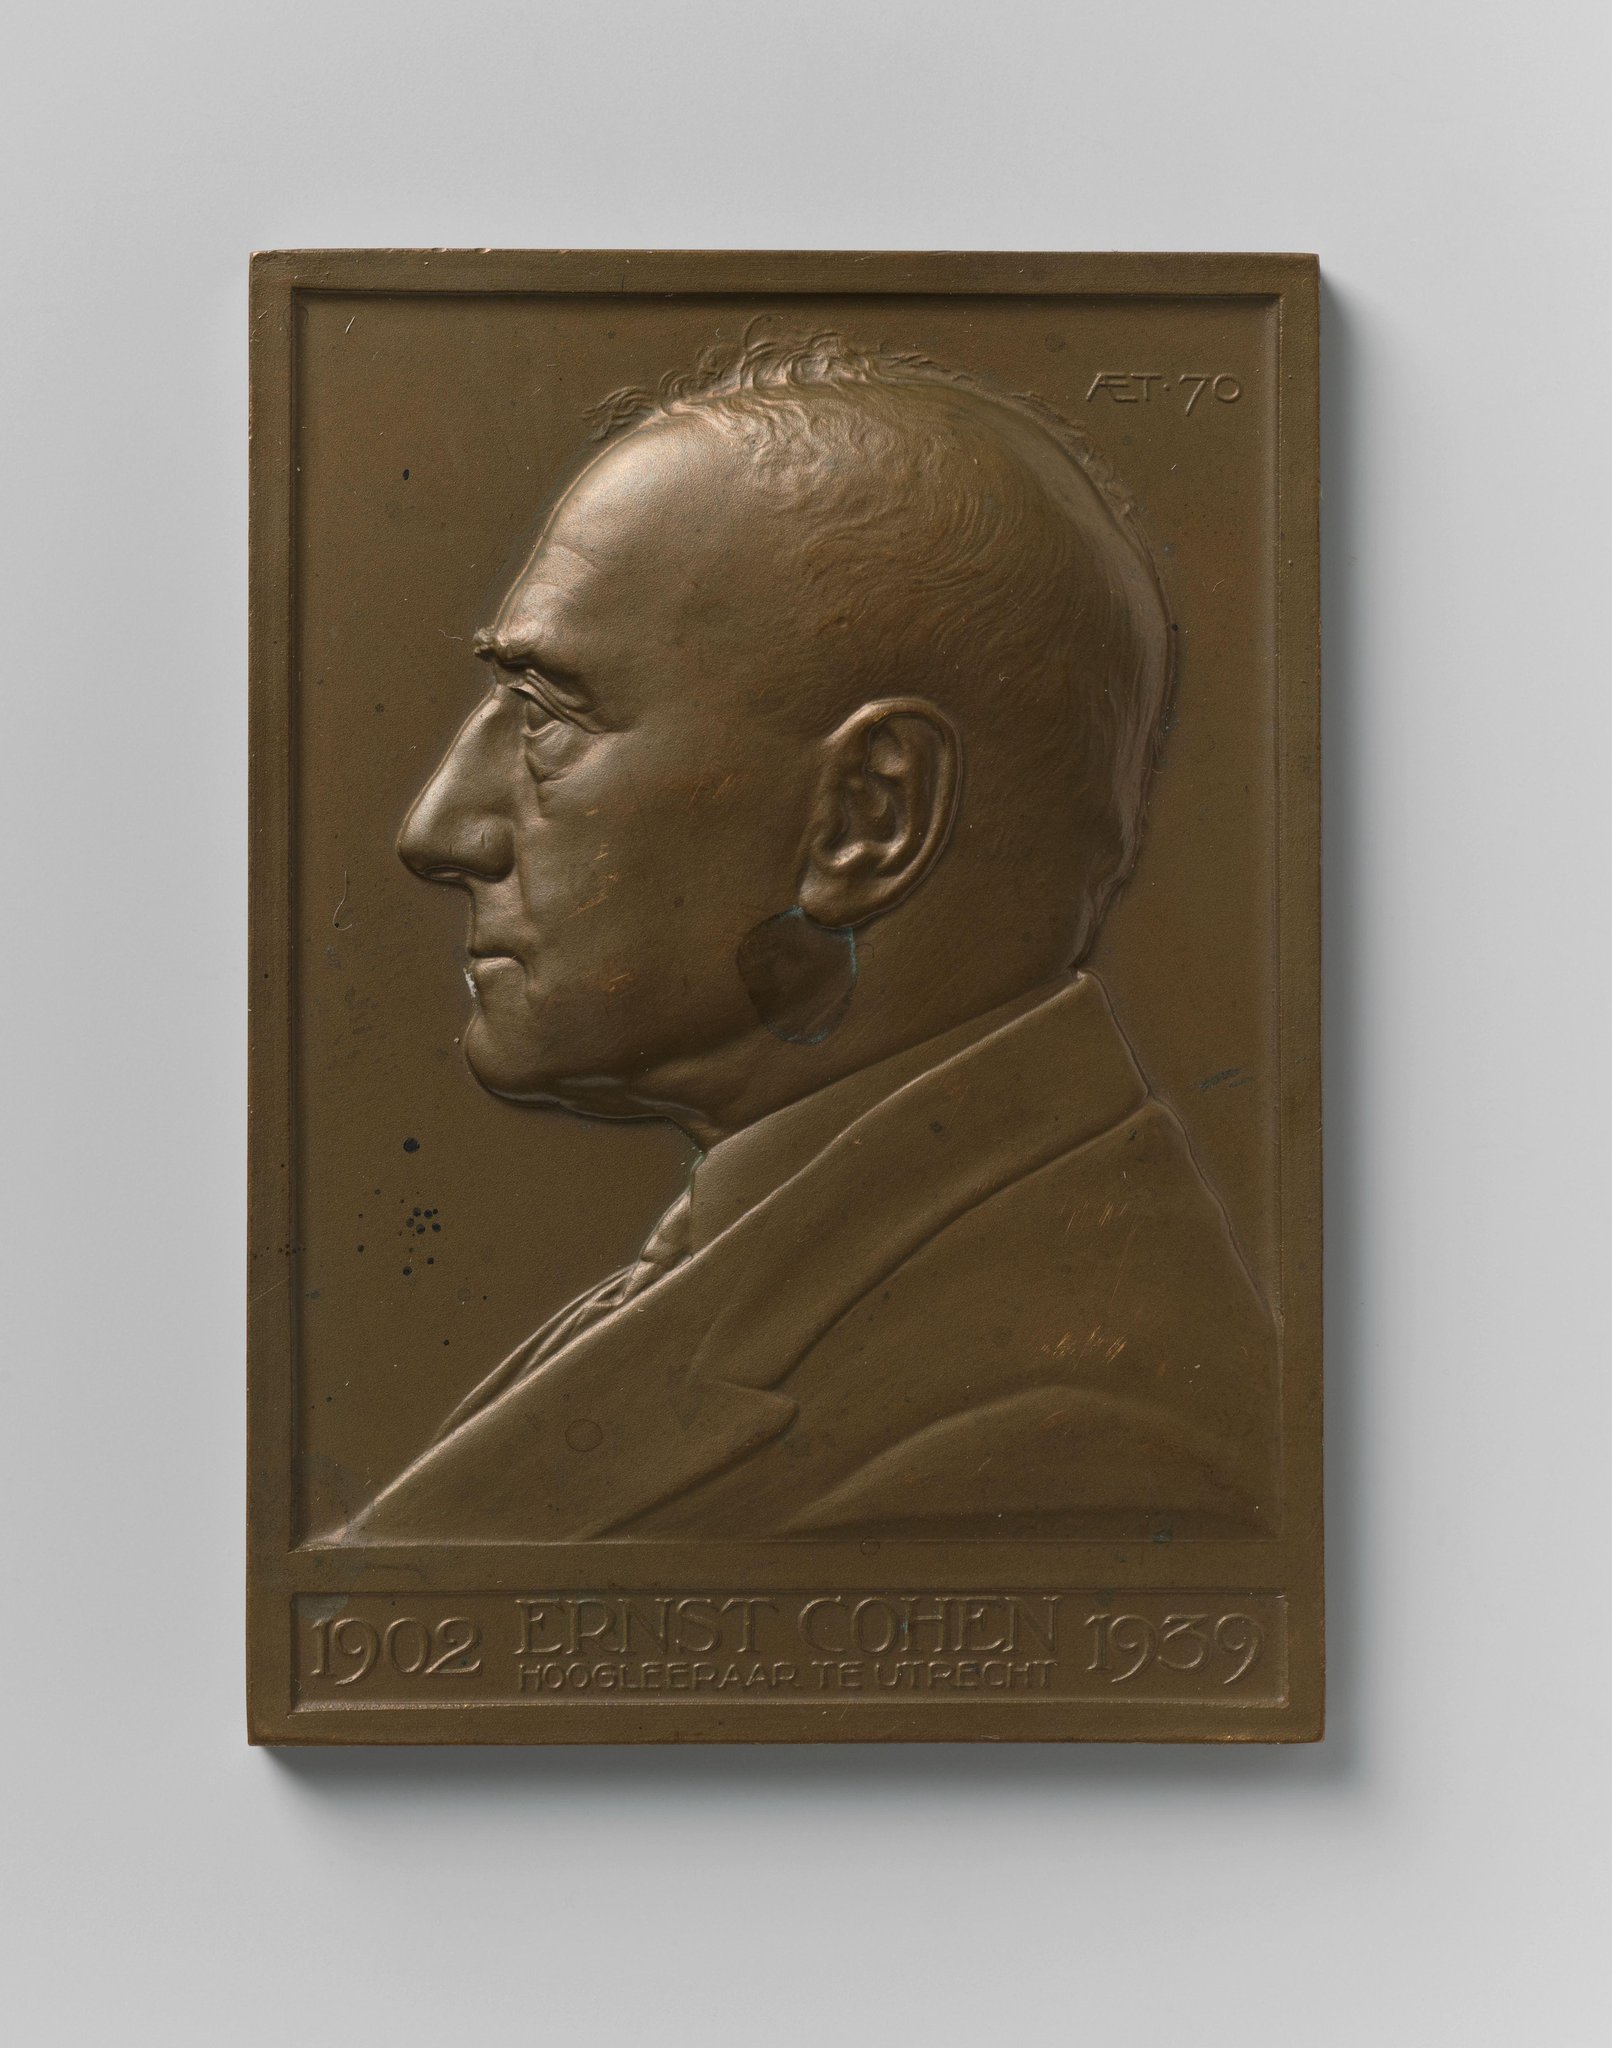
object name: history medal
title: Ernst Cohen hoogleraar te Utrecht 1902-1939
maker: jacob jan van goor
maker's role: medailleur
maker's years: 1874-1956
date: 1939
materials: bronze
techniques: striking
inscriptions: signature: ‘Jac. J. van Goor’, inscription: ‘AET.70’, factory mark: ‘KON. BEGEER / VOORSCHOTEN’, inscription: ‘1902 - ERNST COHEN / HOOGLEERAAR TE UTRECHT - 1939’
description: Eenzijdige bronzen plakette, op de voorzijde het borstbeeld van Cohen naar links, in afsnede twee regels tekst tussen twee jaartallen, de keerzijde blanco.